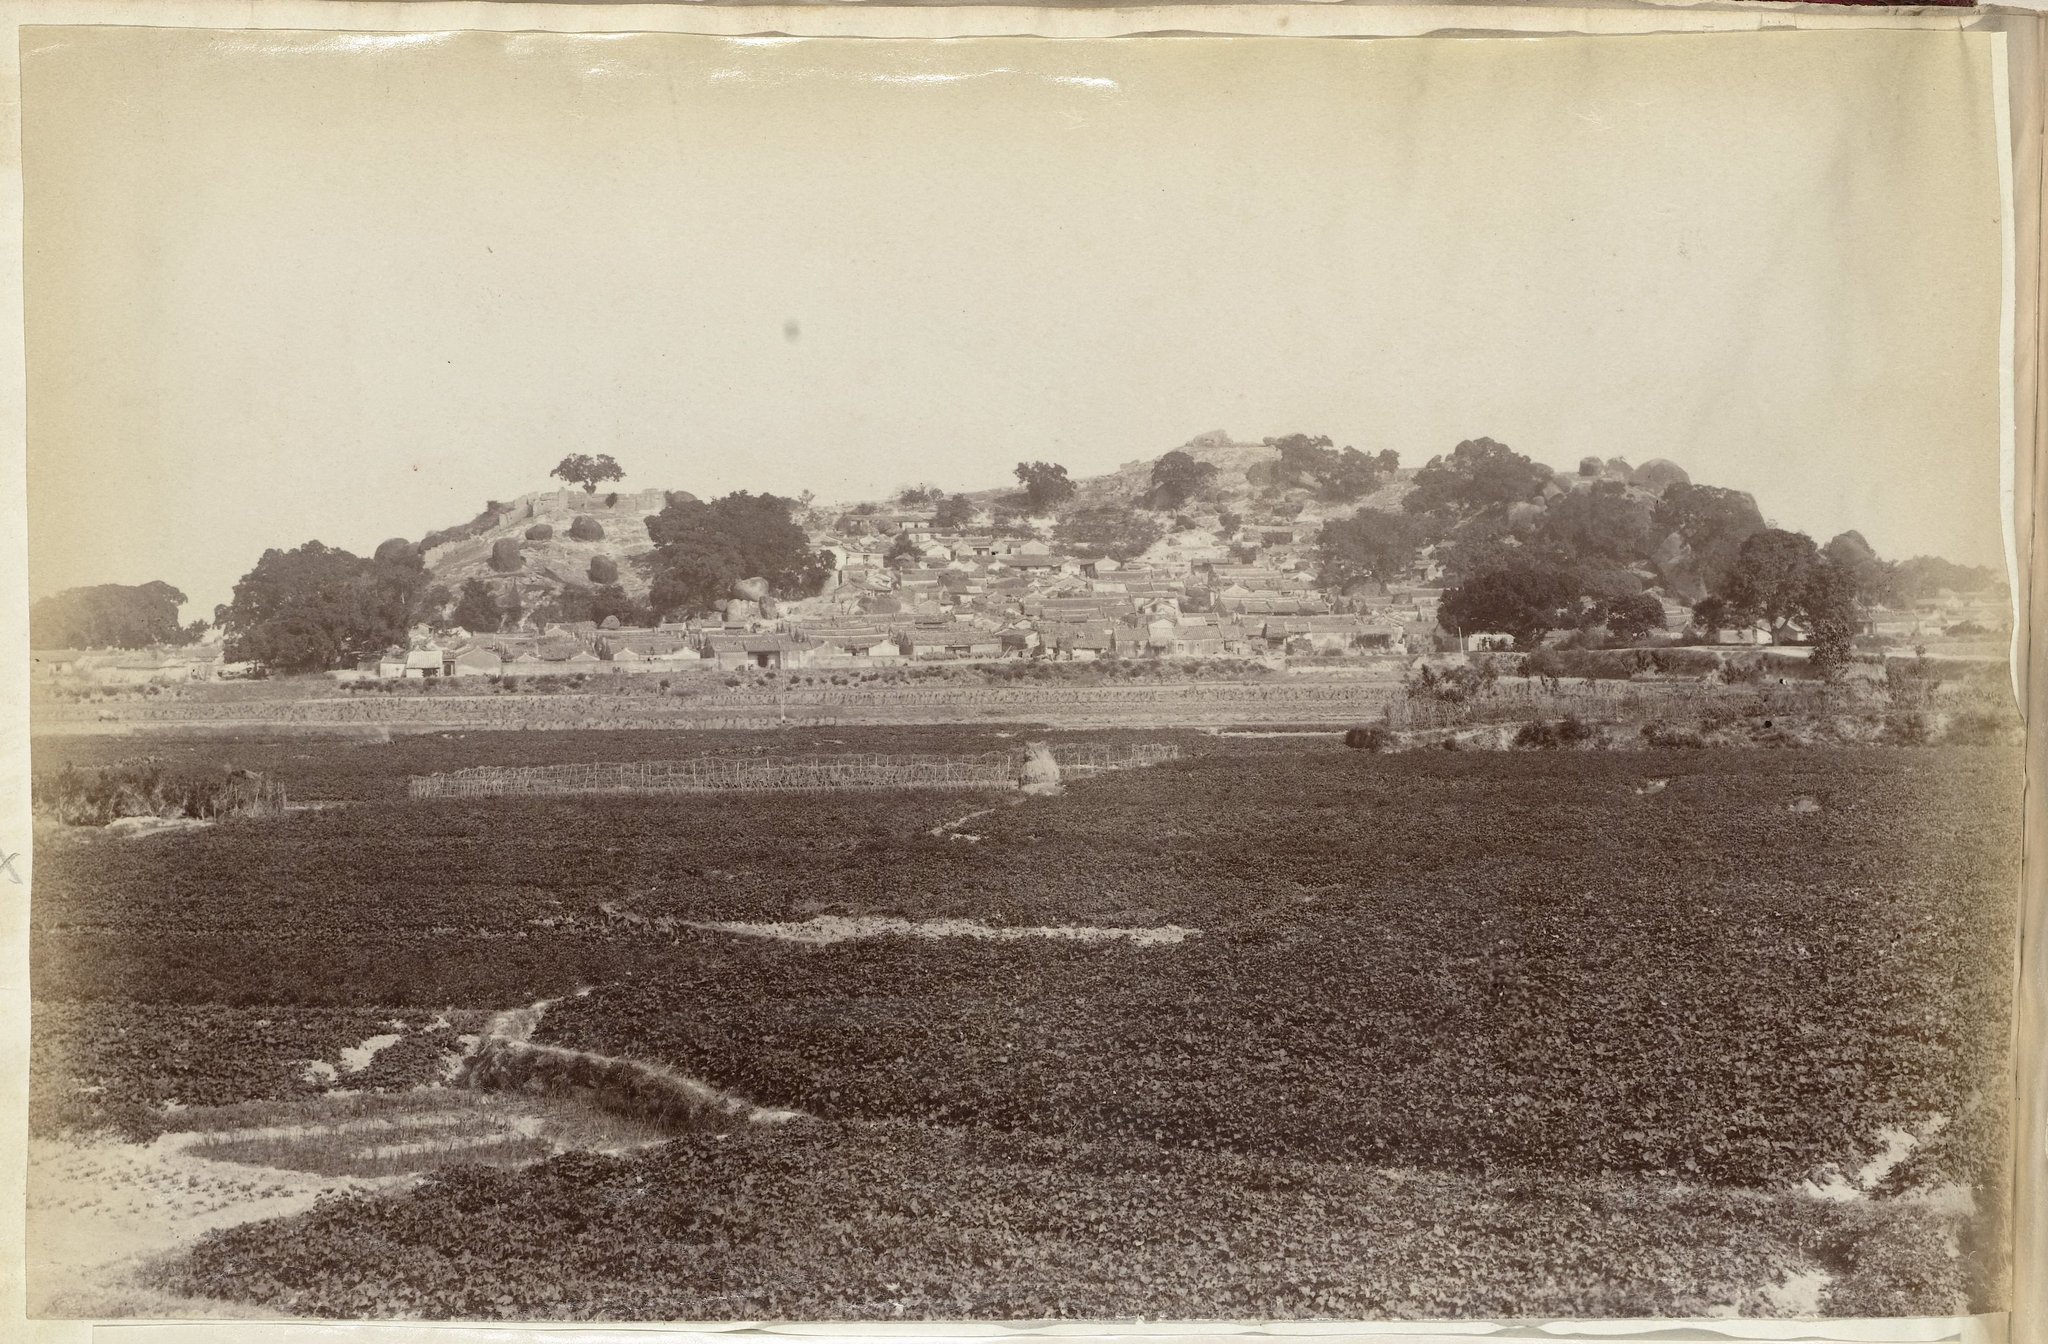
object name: album leaf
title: Gezicht op theevelden en een dorp op een heuvel, China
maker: Anonymous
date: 1879-1890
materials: paper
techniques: albumen print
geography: china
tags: prospect of village, silhouette of village, low hill country, tea (leaves), china